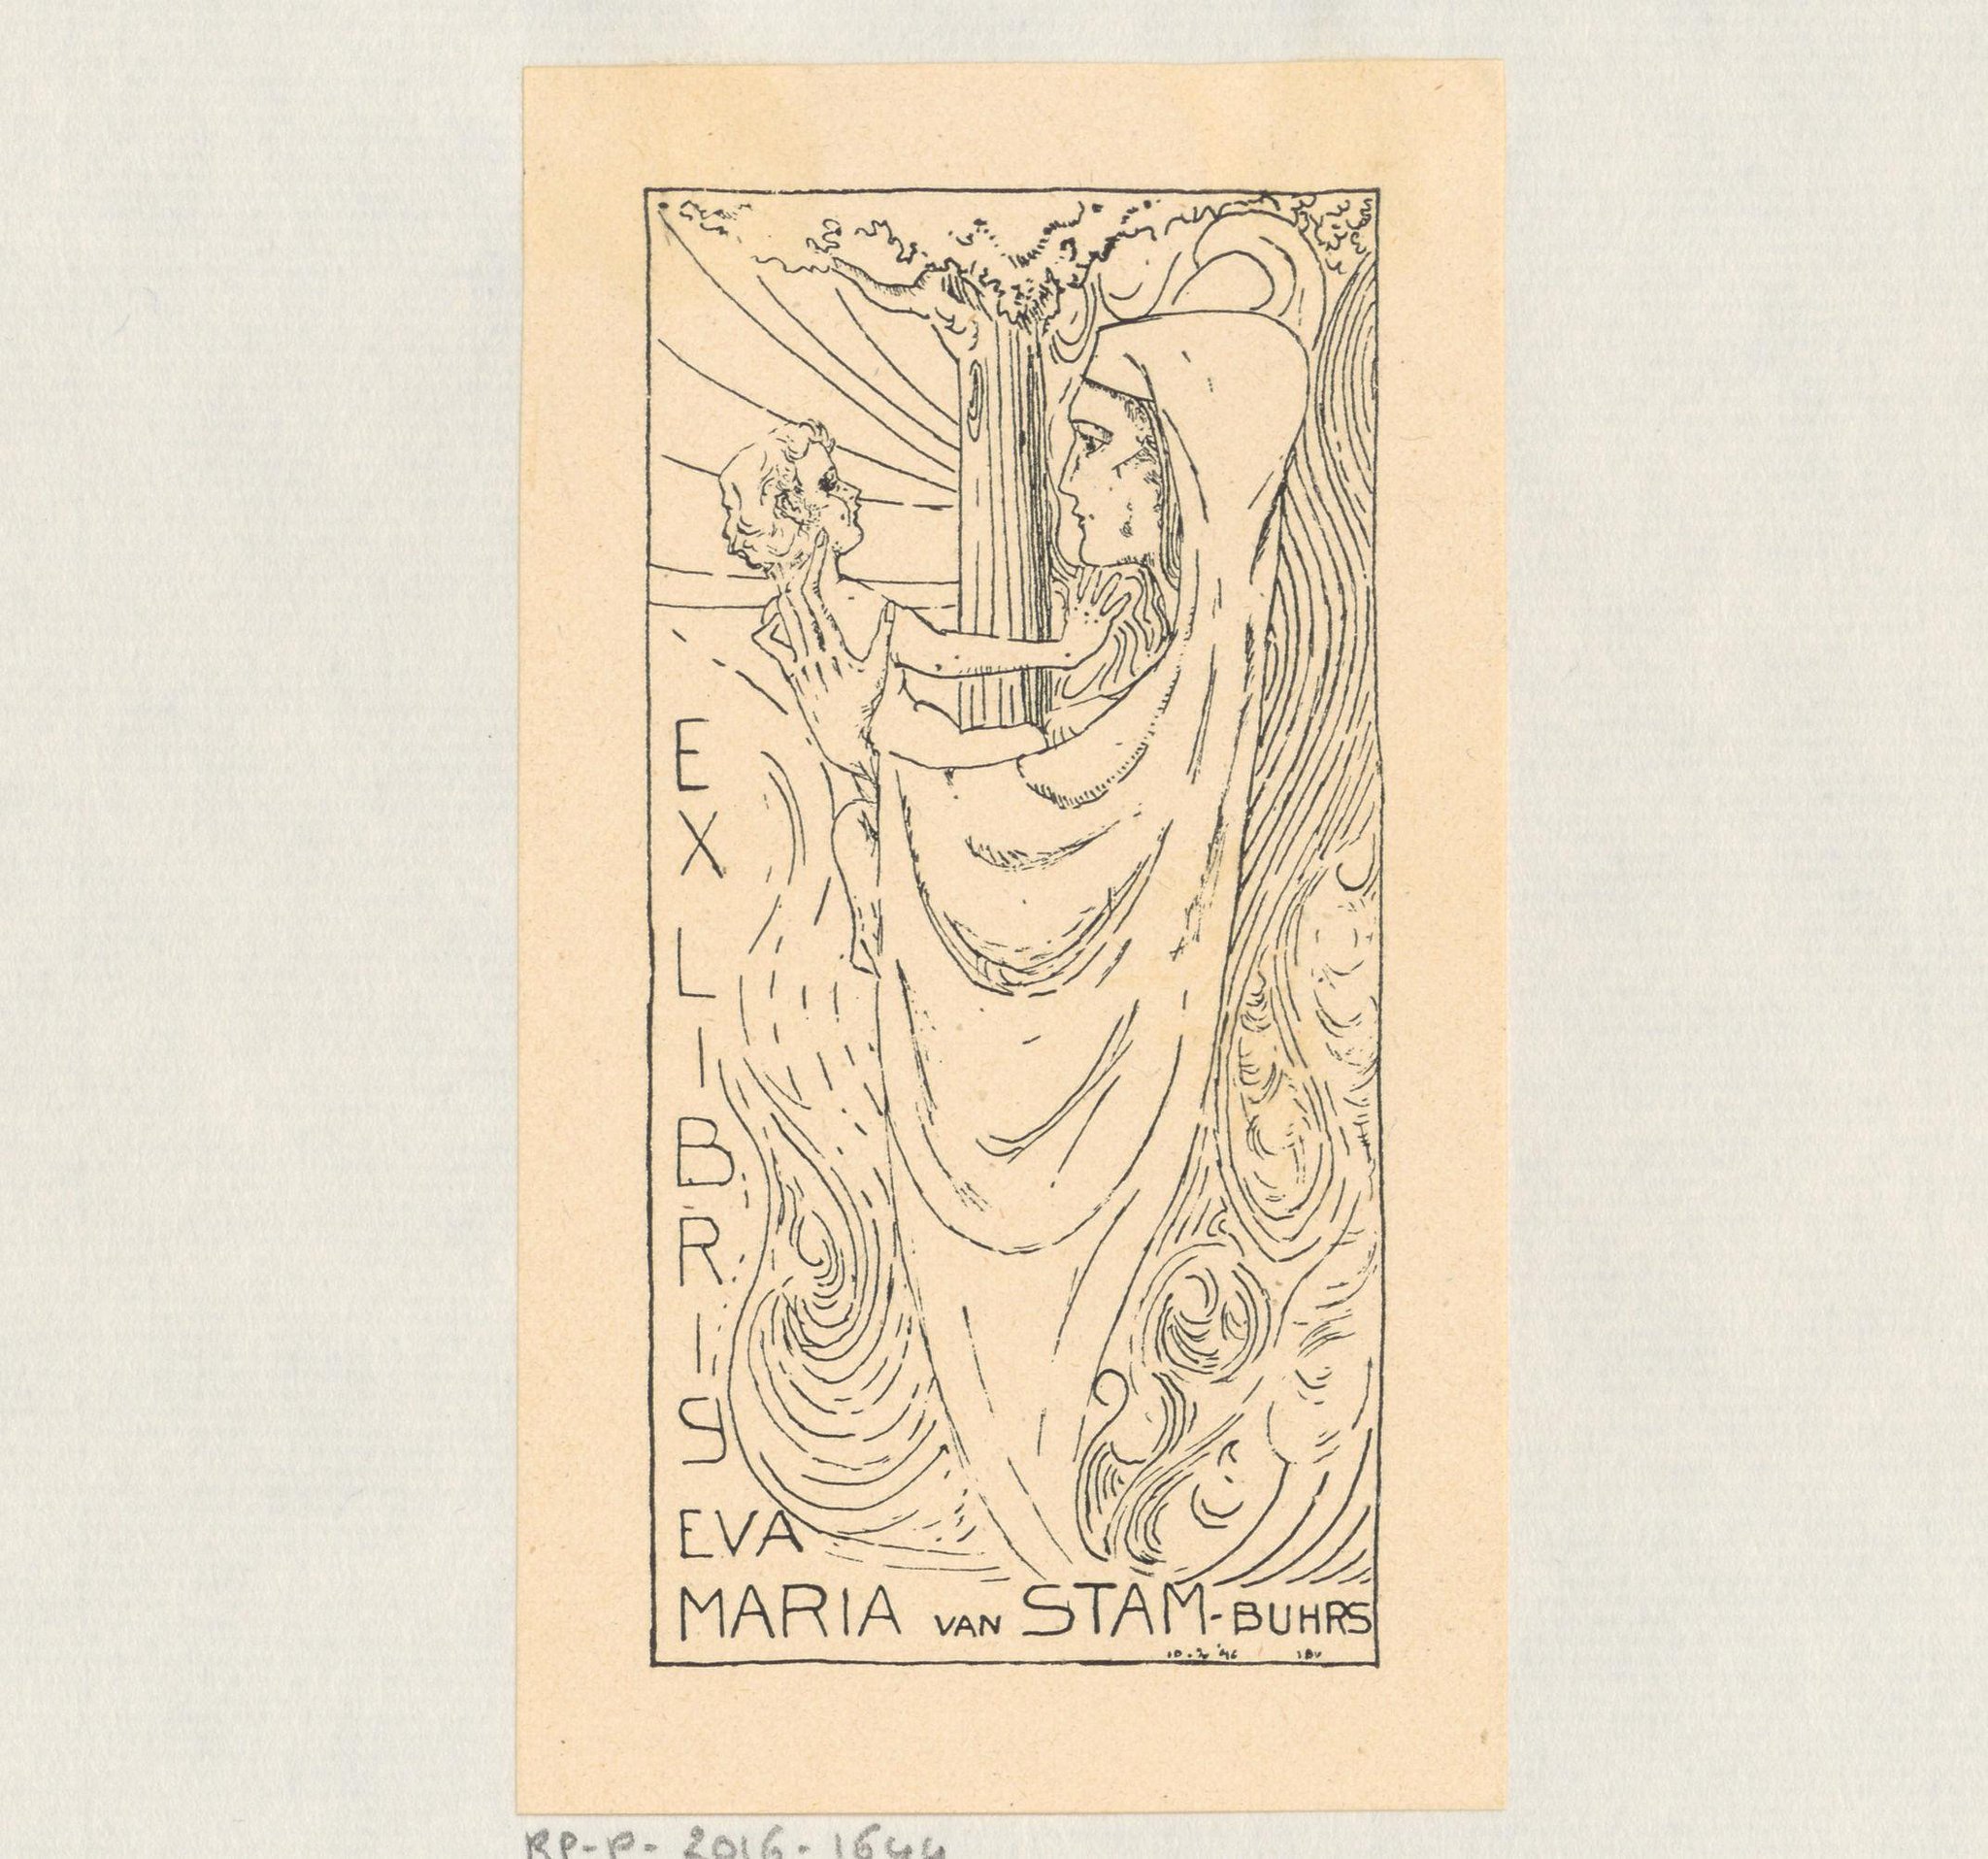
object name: bookplate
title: Ex libris van Eva Maria van Stam-Buhrs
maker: joop vuurmans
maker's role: print maker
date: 1946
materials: paper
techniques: printing block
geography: zeist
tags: madonna: i.e. mary with the christ-child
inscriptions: inscription: ‘Joop Vuurmans Zeist / Nederland / Cl. 46’